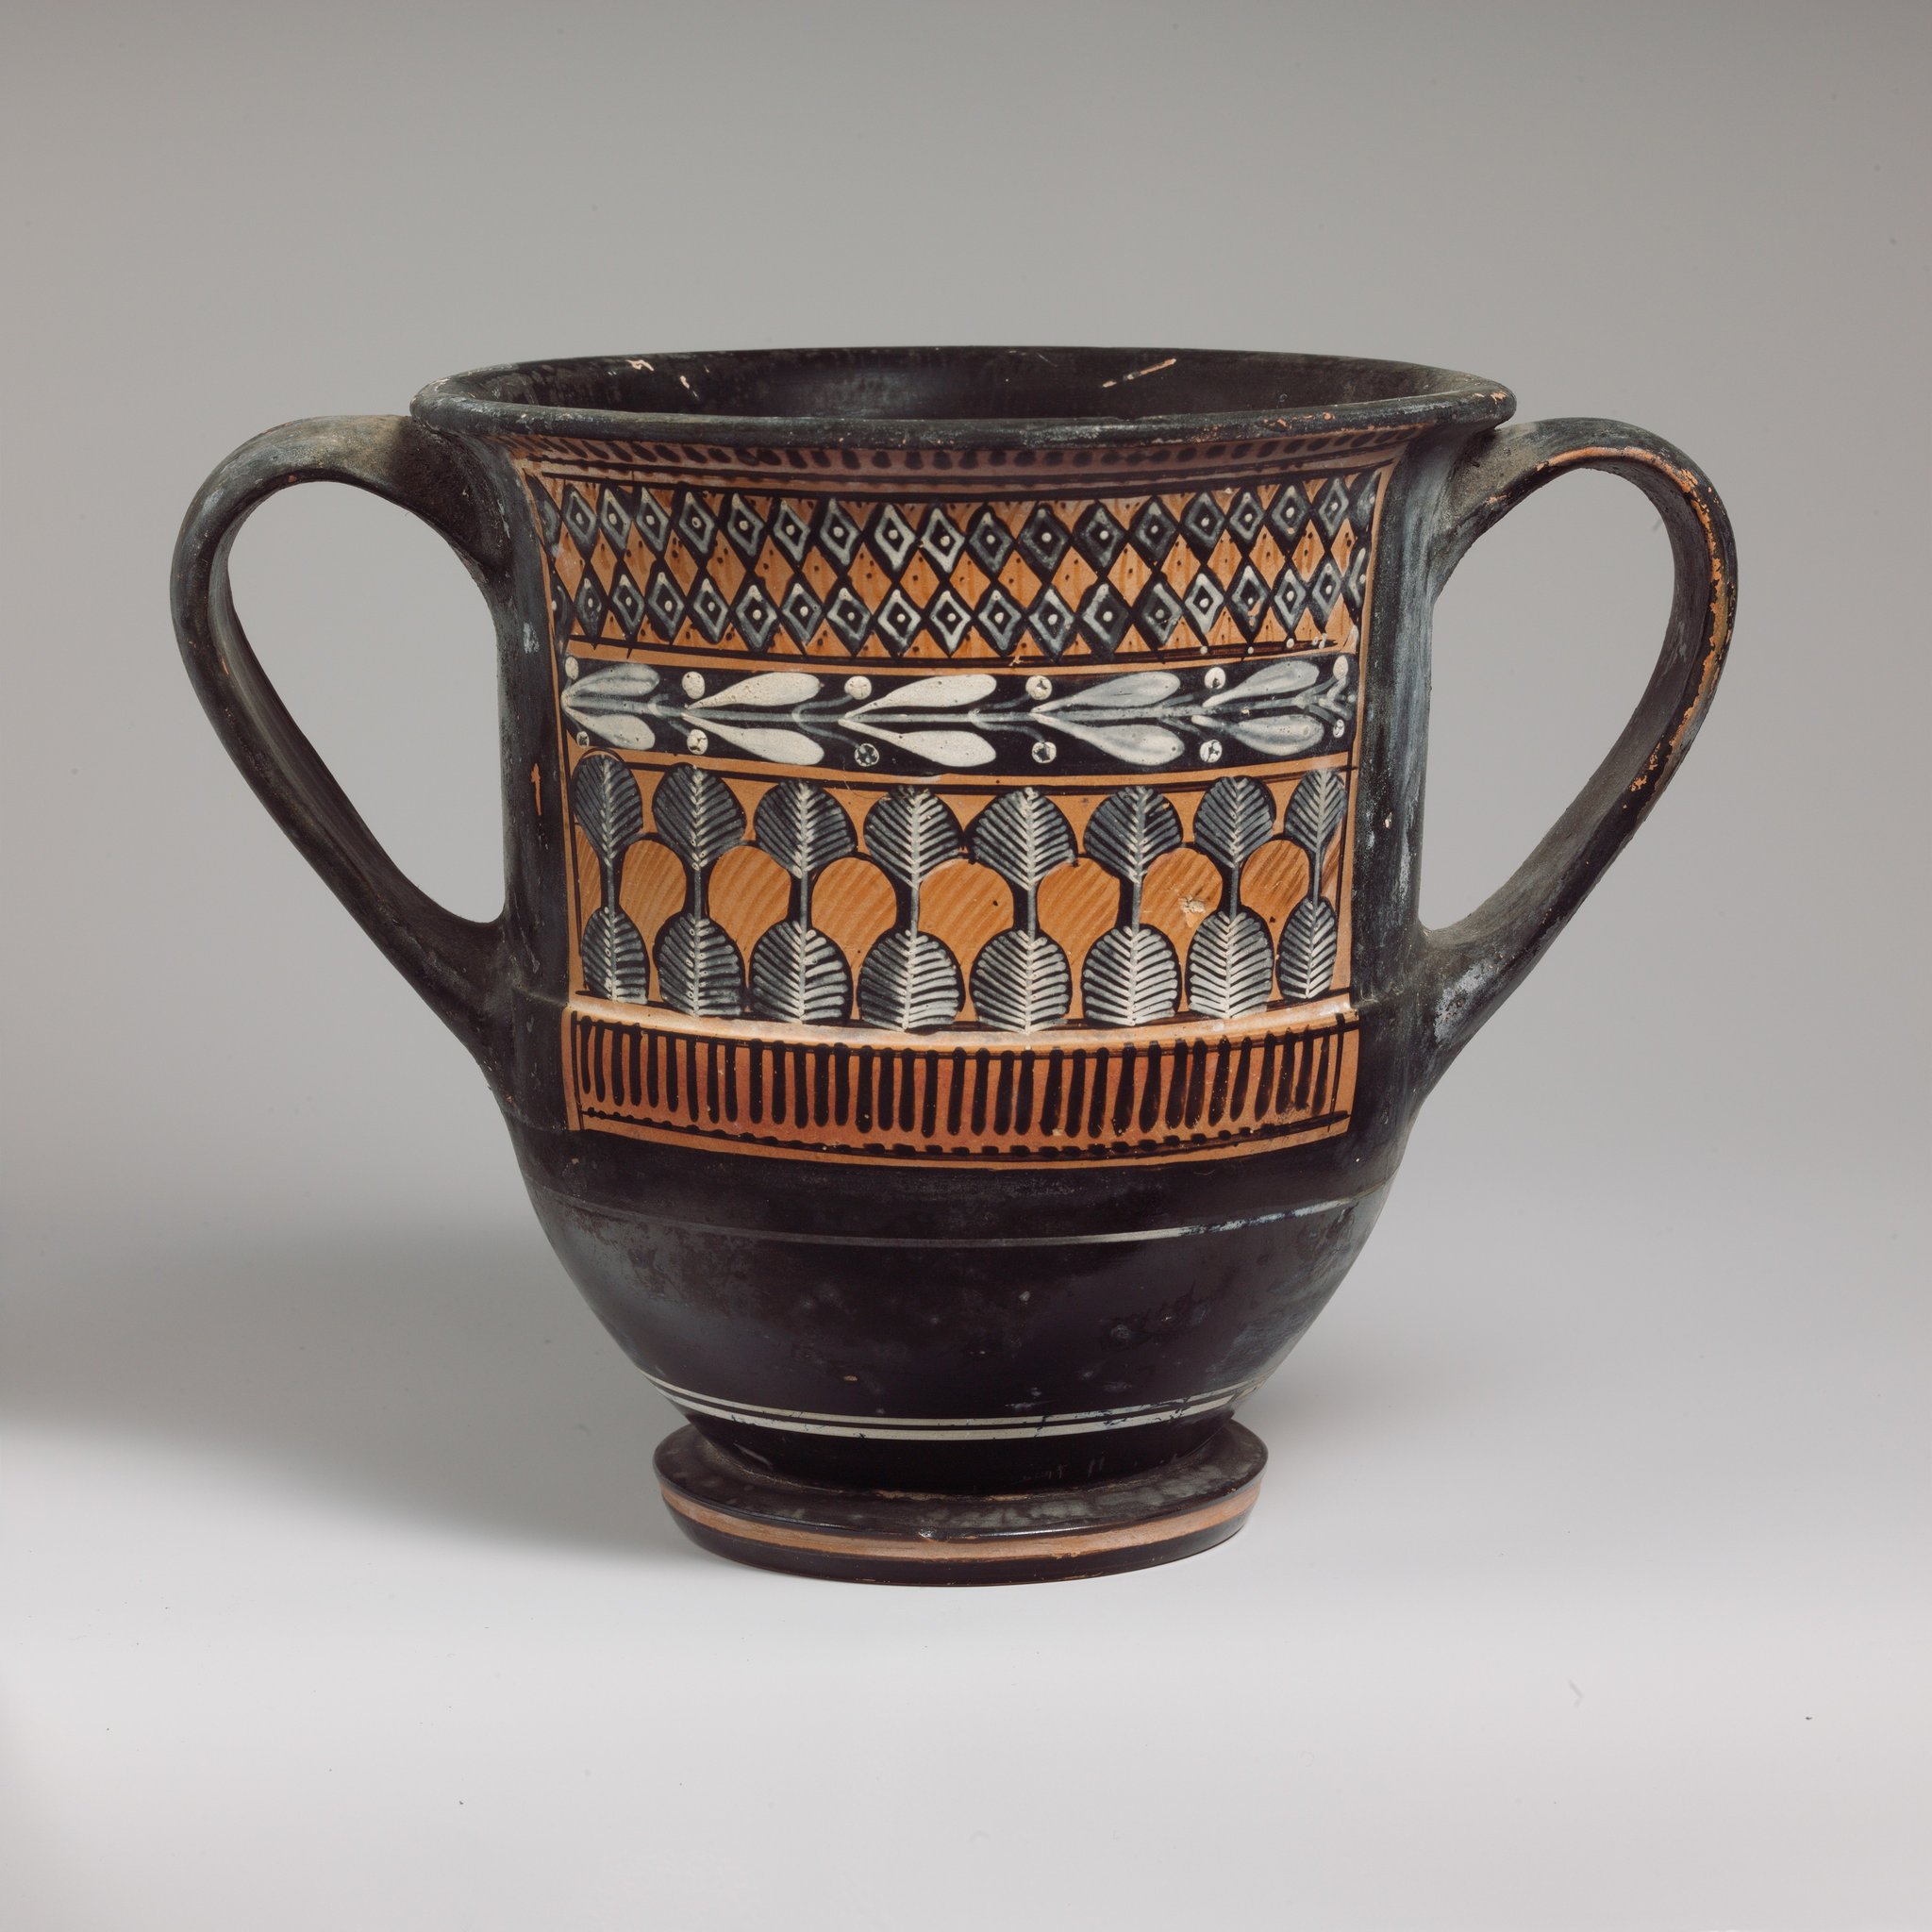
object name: kantharos, sessile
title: Terracotta sessile kantharos (deep cylindrical drinking cup with two handles)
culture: greek, attic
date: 450 BCE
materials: terracotta